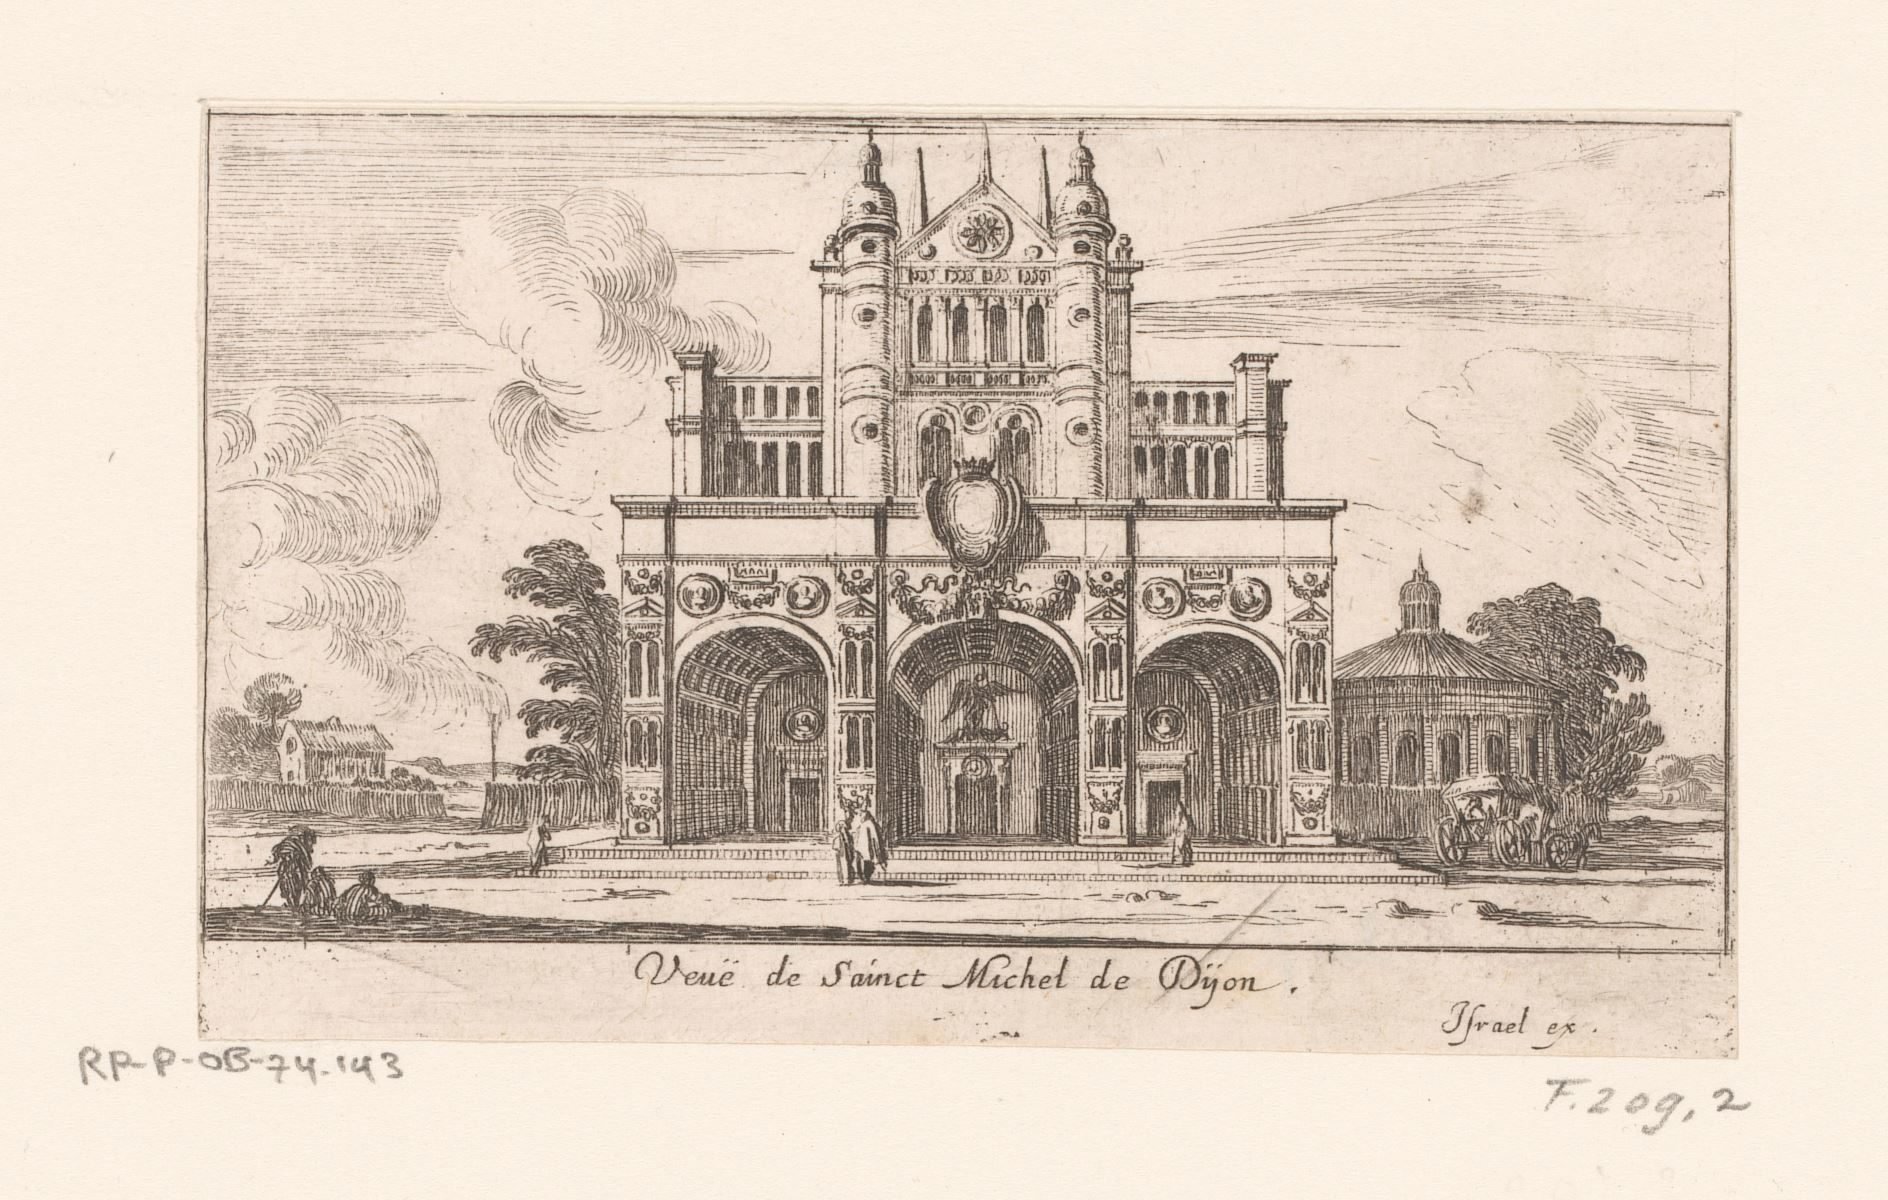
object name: print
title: Veue de sainct Michel de Dijon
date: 1631-1661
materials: paper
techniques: engraving, etching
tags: parts of church exterior and annexes: façade, city-view, and landscape with man-made constructions (+ city(-scape) with figures, staffage)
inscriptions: collector's mark: Lugt 240